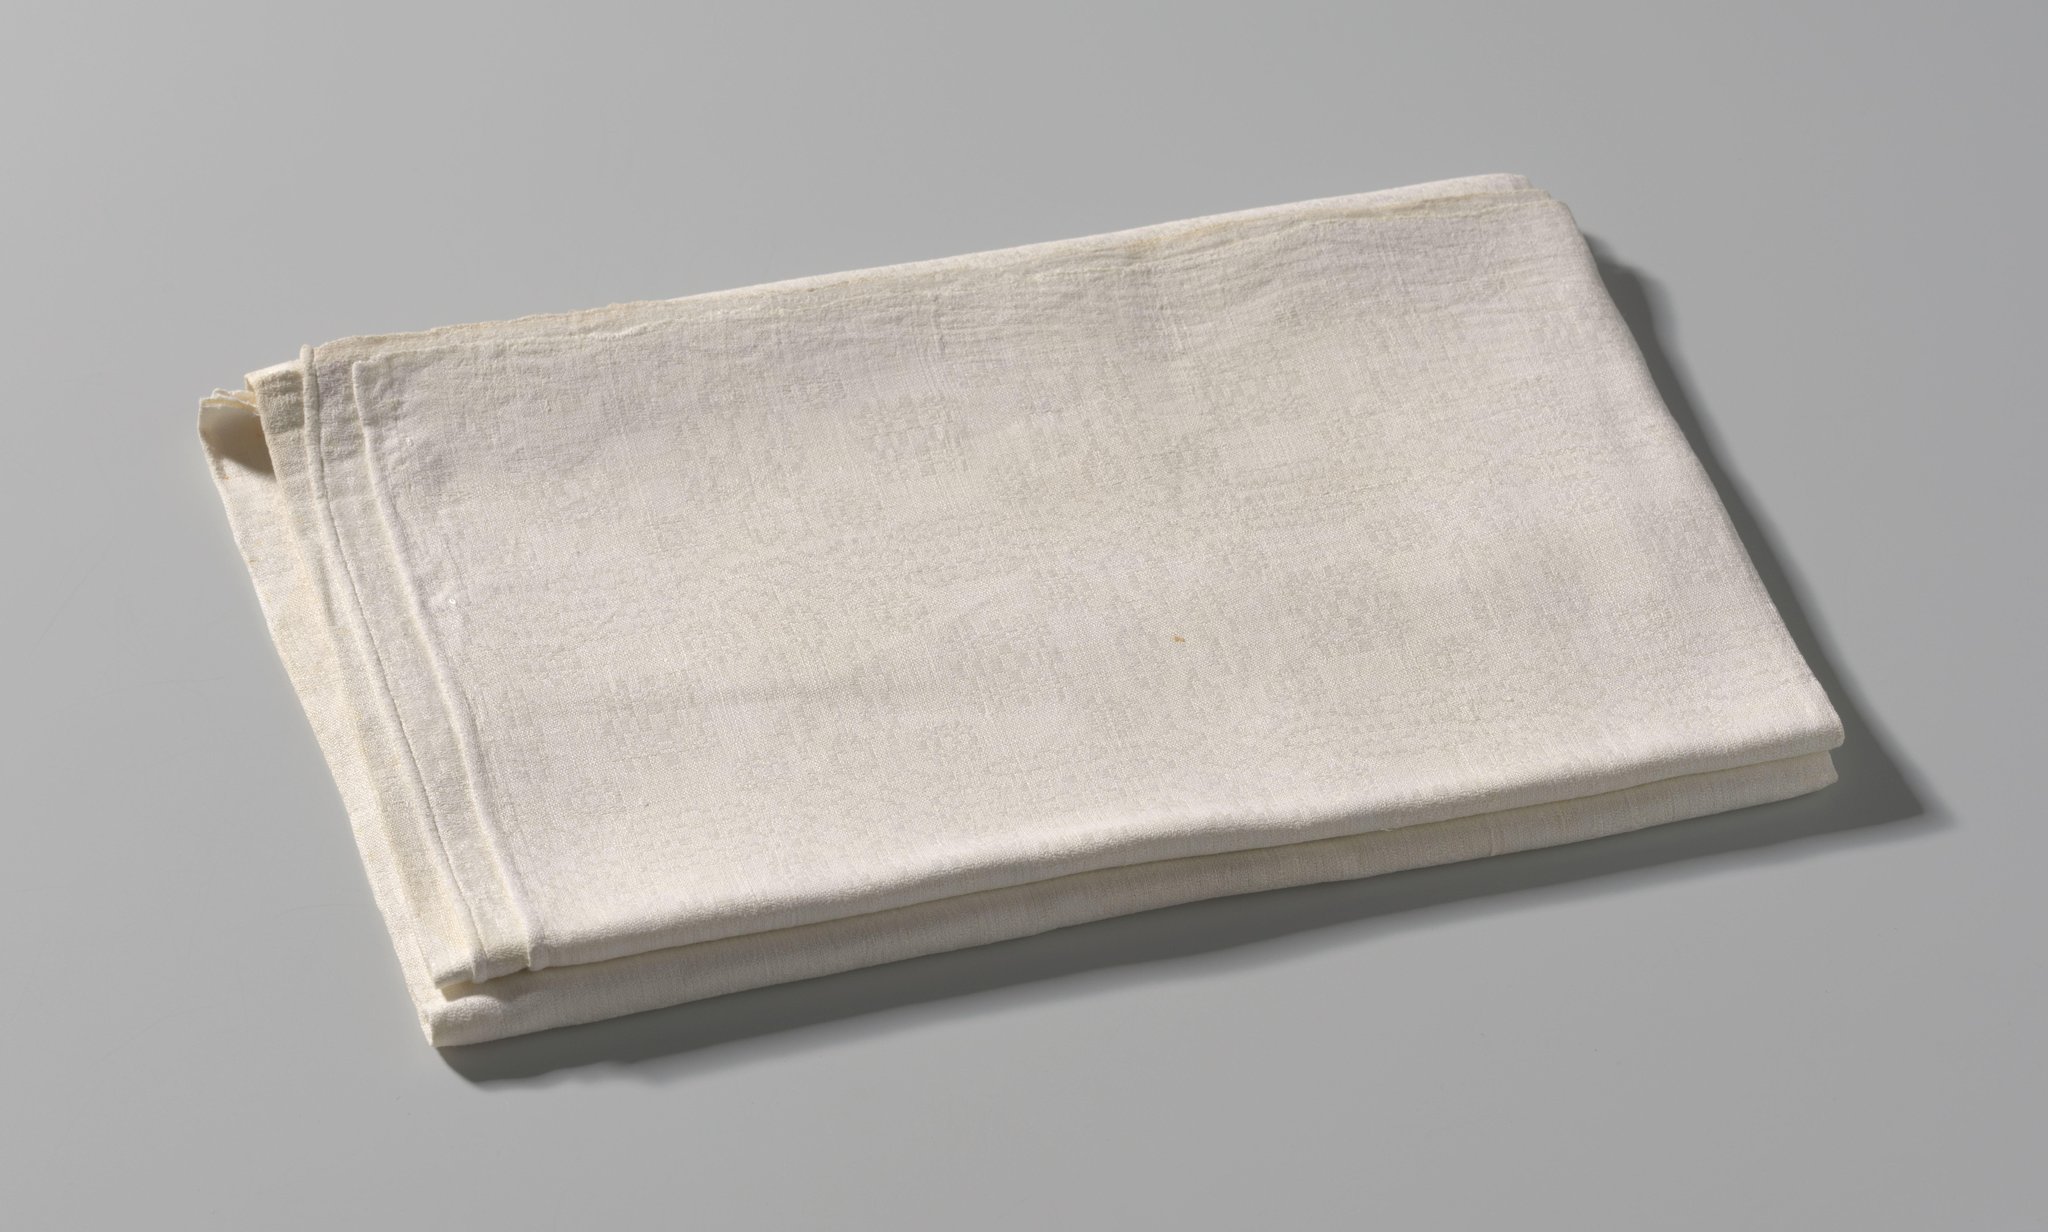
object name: napkin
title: Servet van pellendamast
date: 1700-1800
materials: linen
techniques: cross stitching, weave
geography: northern netherlands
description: Servet van linnen pellendamast. Het patroon heeft grote vierkanten gevormd door brede geometrische randen van ruiten en ovalen. Binnen de vierkanten vijf vierkanten. Het servet is in rode kruissteek gemerkt: DR 38 en heeft een aangenaaid nummer 1193 in rood op wit.